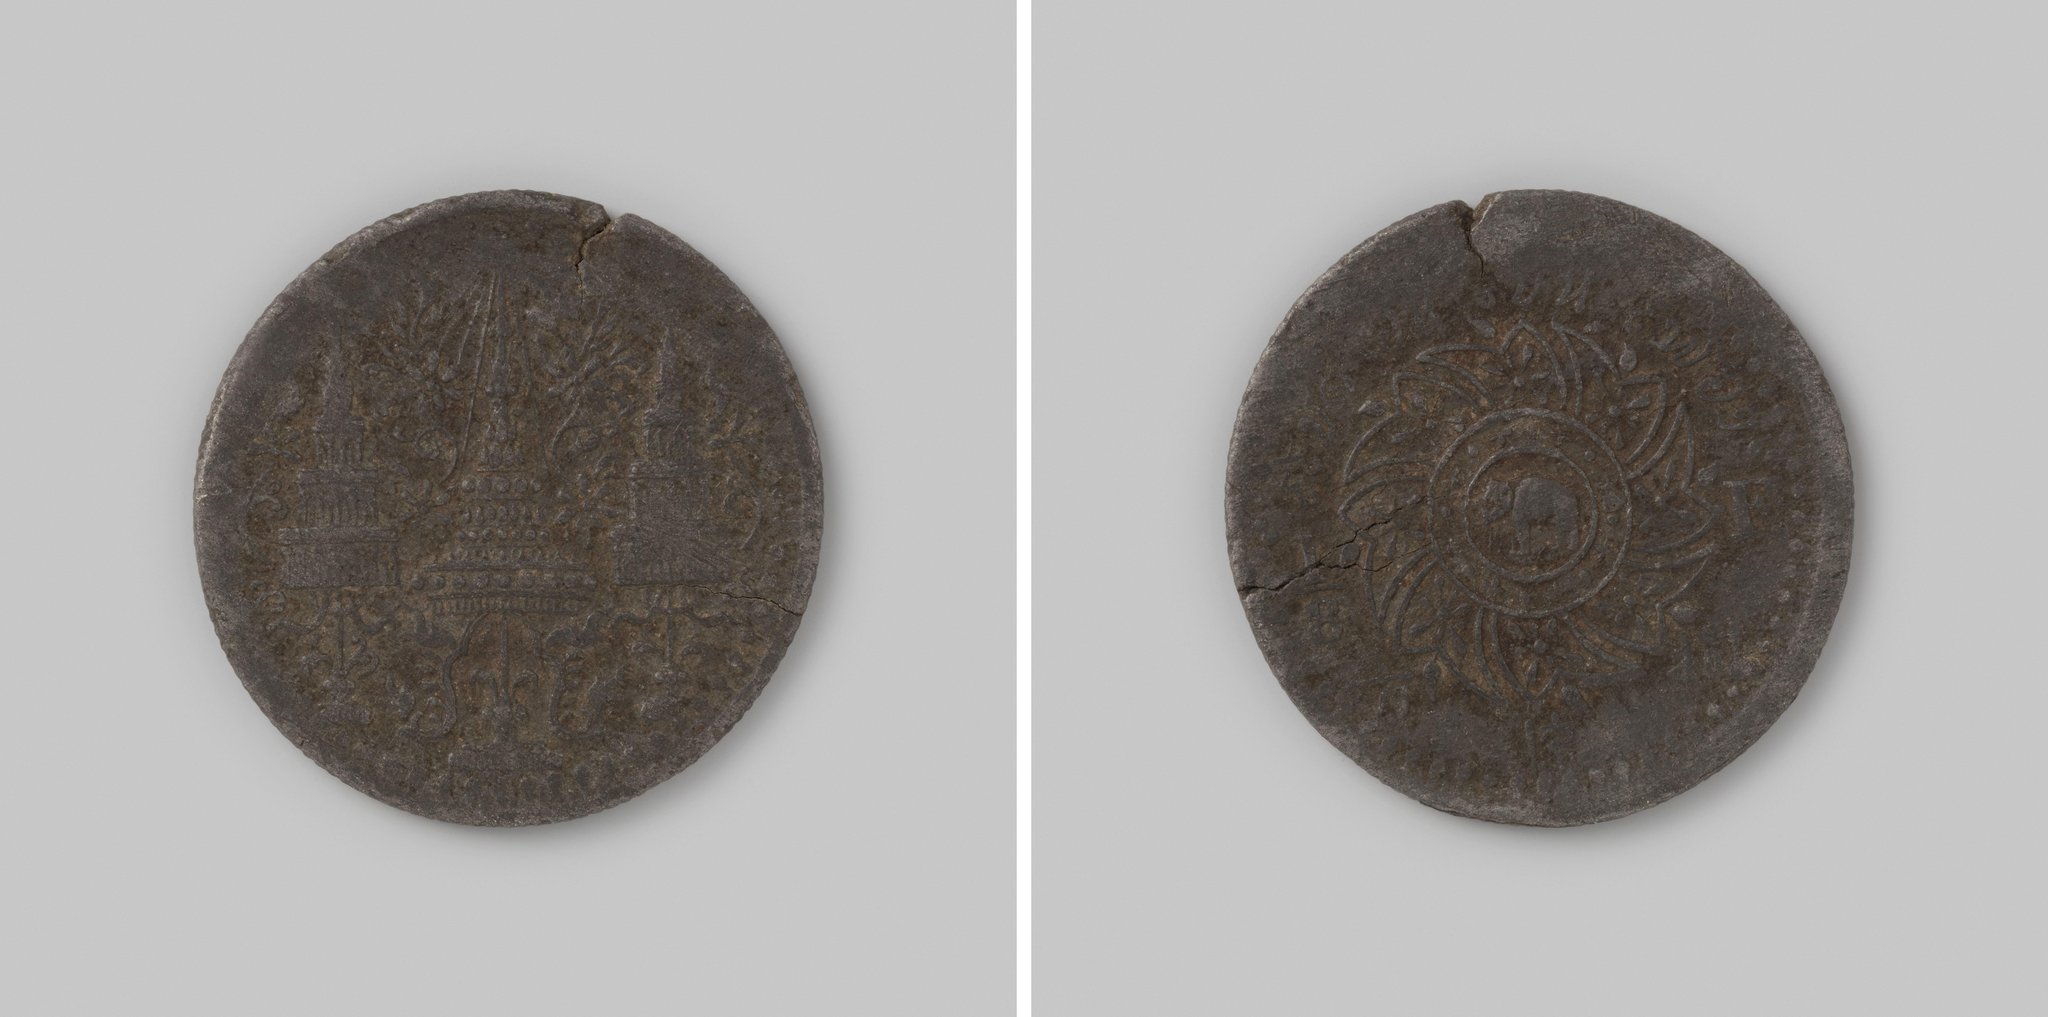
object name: coin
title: 1/8 fuang of att uit Thailand, Maha Mongkut,1851-1868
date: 1862-1868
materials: tin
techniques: striking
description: Tinnen munt. Voorzijde: tussen twee uitvouwbare schermen koninklijke kroon van Thailand. Keerzijde: tussen waarde-aanduiding 1/8 F chakra met in het midden een olifant. Boven en onder 1/8 de waarde-aanduidingen in het Thais en het Chinees. Kartelrand.